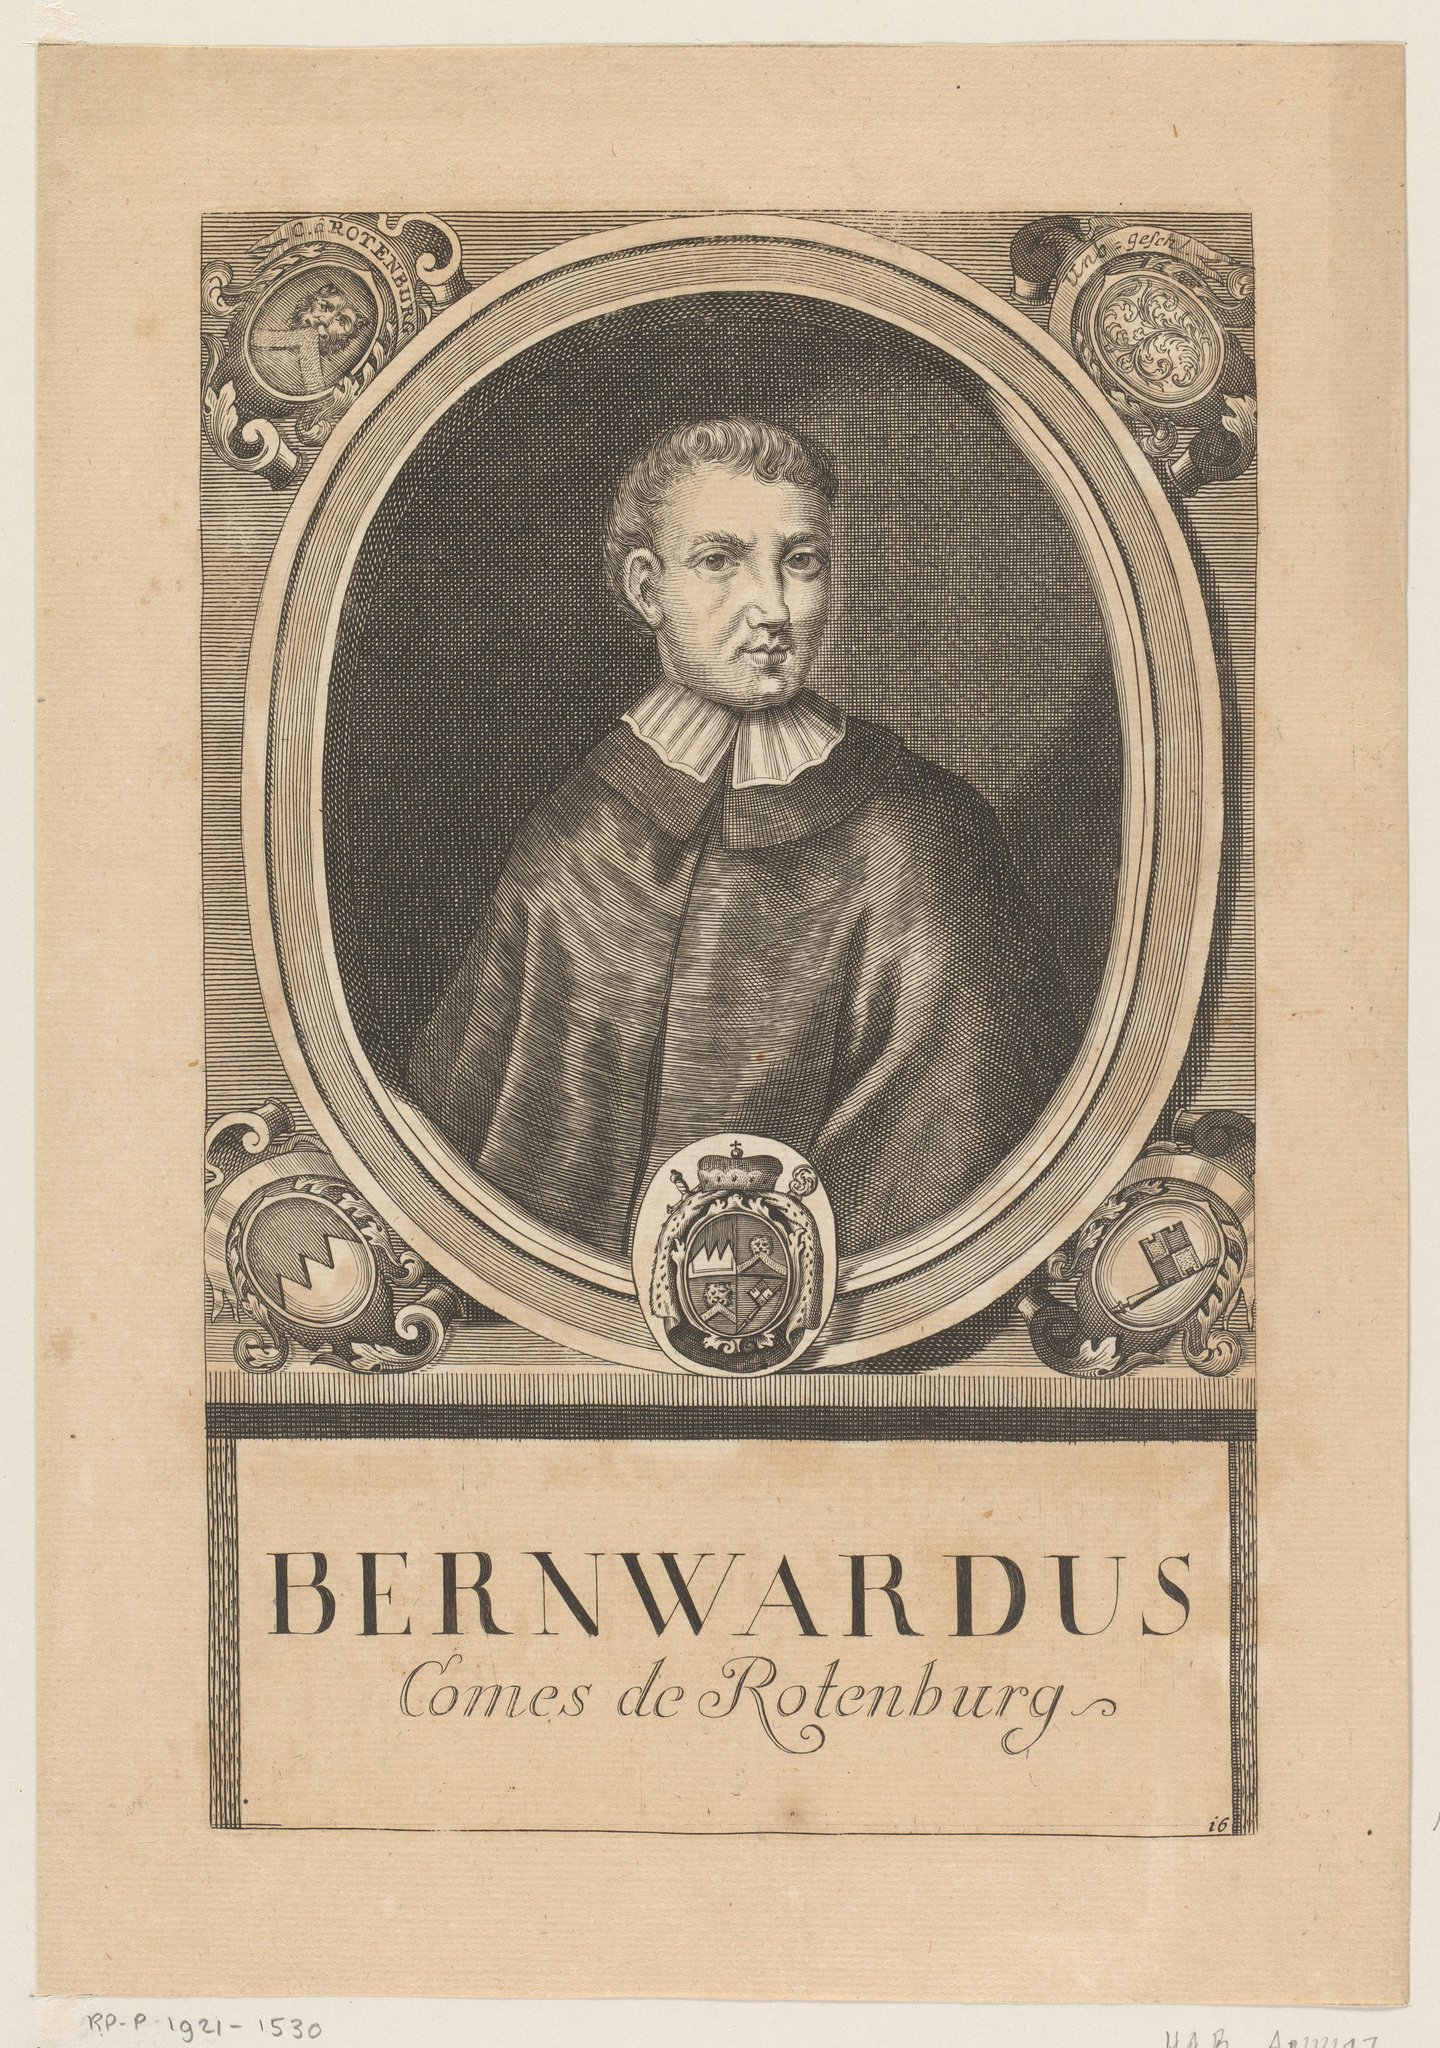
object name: book illustration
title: Bernwardus comes de Rotenburg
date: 1713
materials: paper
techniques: engraving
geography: frankfurt am main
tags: archbishop, bishop, etc. (roman catholic), historical persons, armorial bearing, heraldry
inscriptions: collector's mark: Lugt 2233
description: Prent uit: Ludewig, Johann Peter von. Geschicht-Schreiber von dem Bischoffthum Wirtzburg (...). Frankfurt am Main: Thomas Fritsch, 1713.